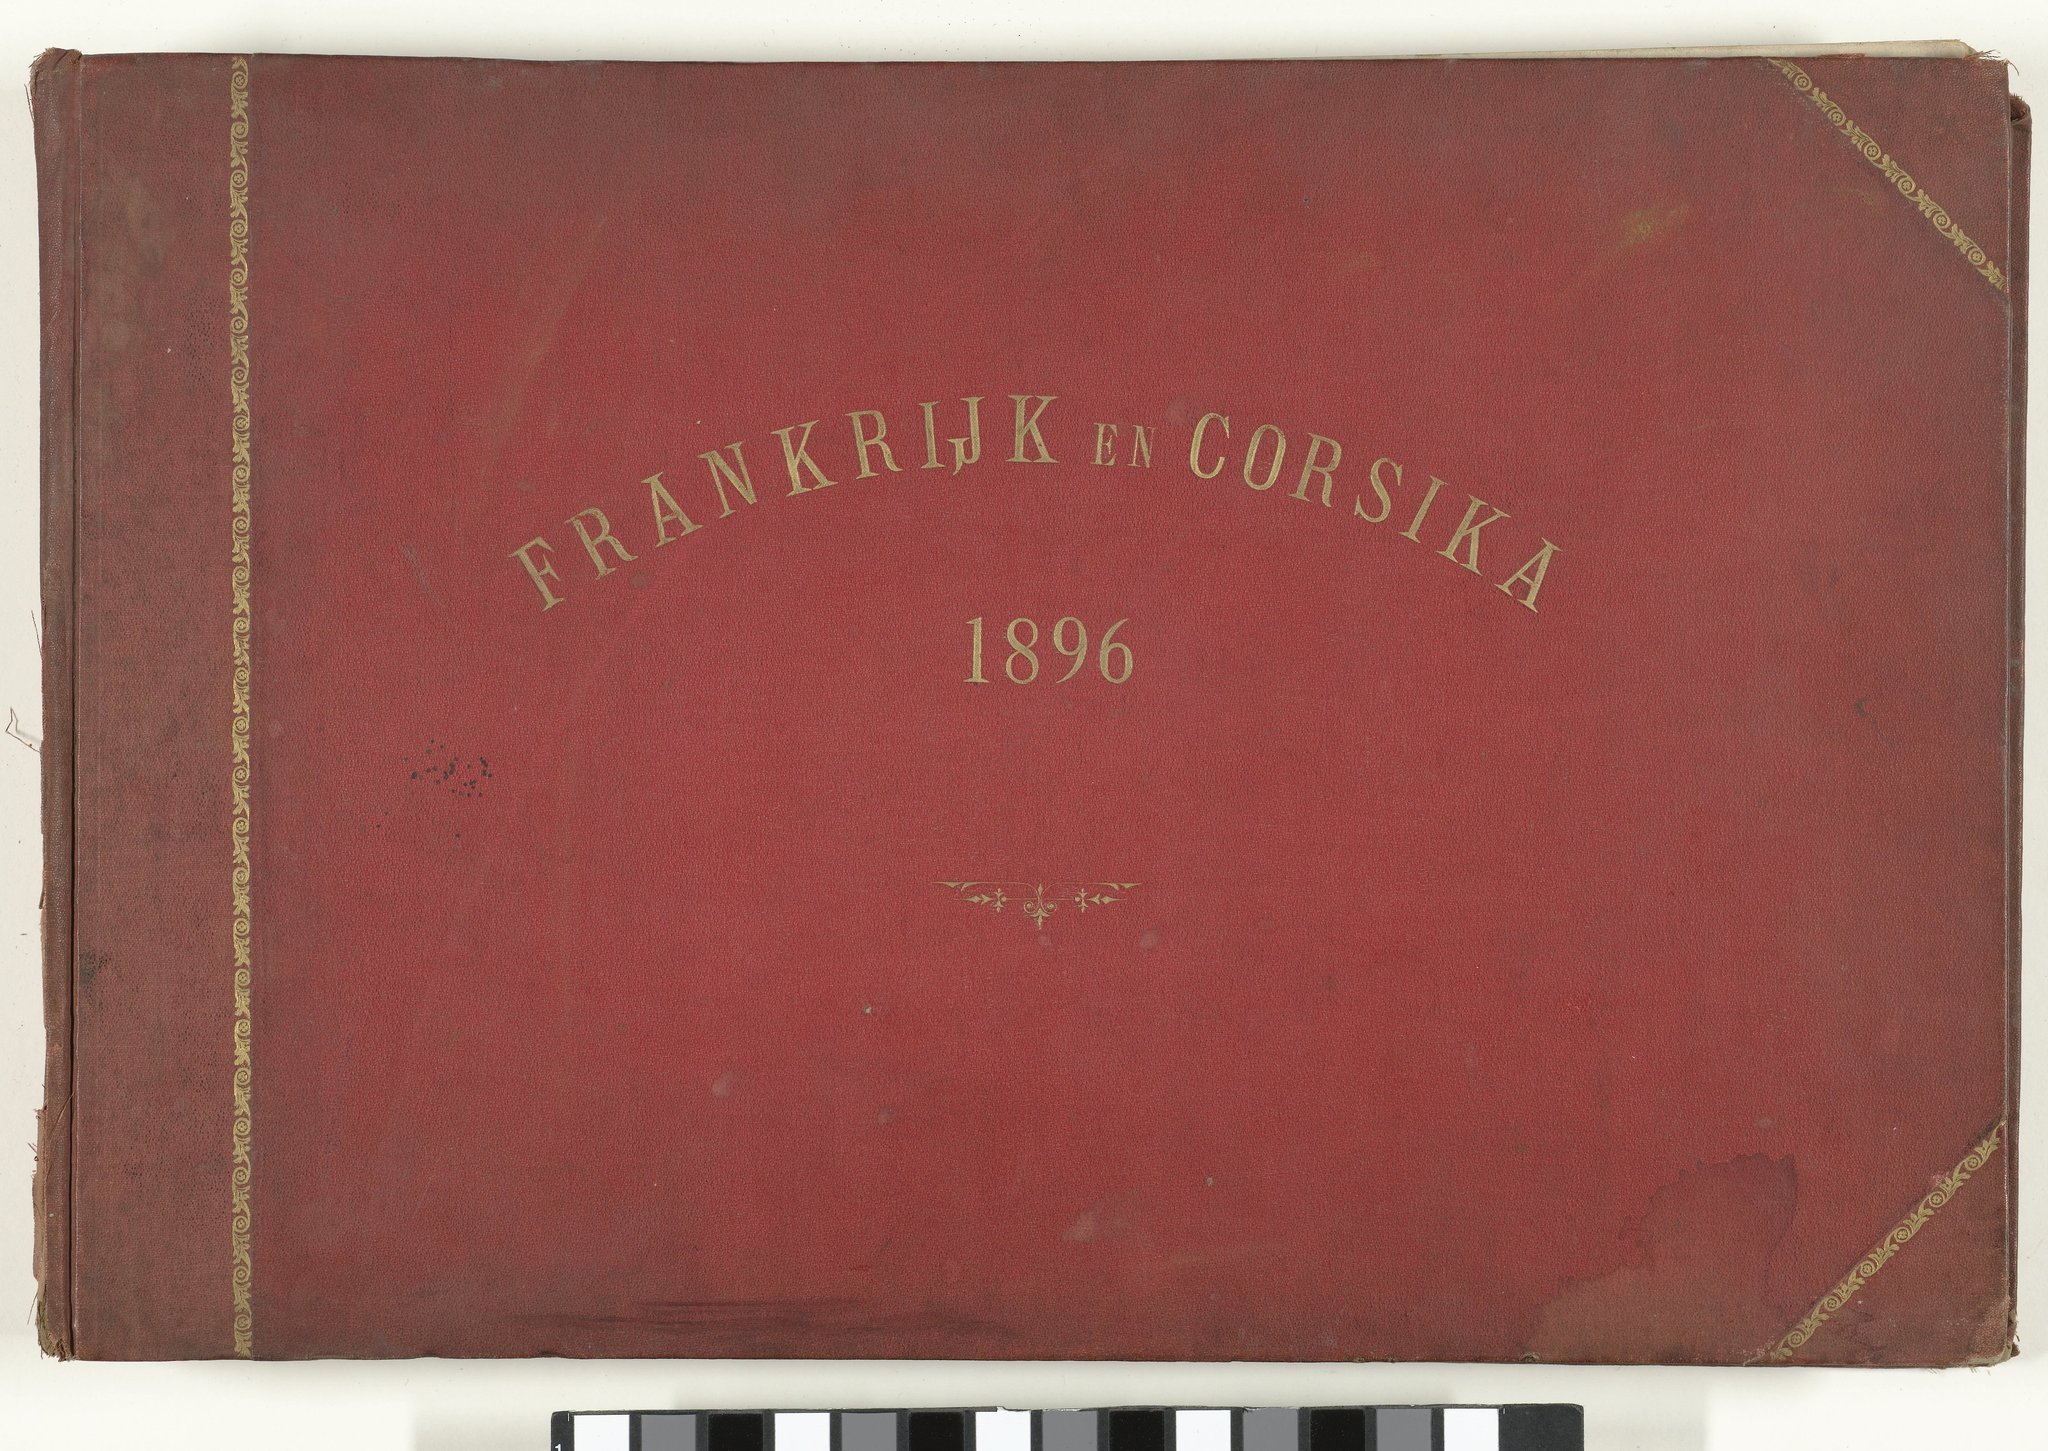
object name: photograph album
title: Frankrijk, Monaco en Corsica (Italië)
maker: henry pauw van wieldrecht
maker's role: fotograaf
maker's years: 1863-1912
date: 1896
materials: paper, photographic support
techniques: albumen print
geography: netherlands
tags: france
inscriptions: title: ‘FRANKRIJK EN CORSICA / 1896’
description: Fotoalbum met 72 foto's gemaakt in Frankrijk, Monaco en Corsica (Italië).